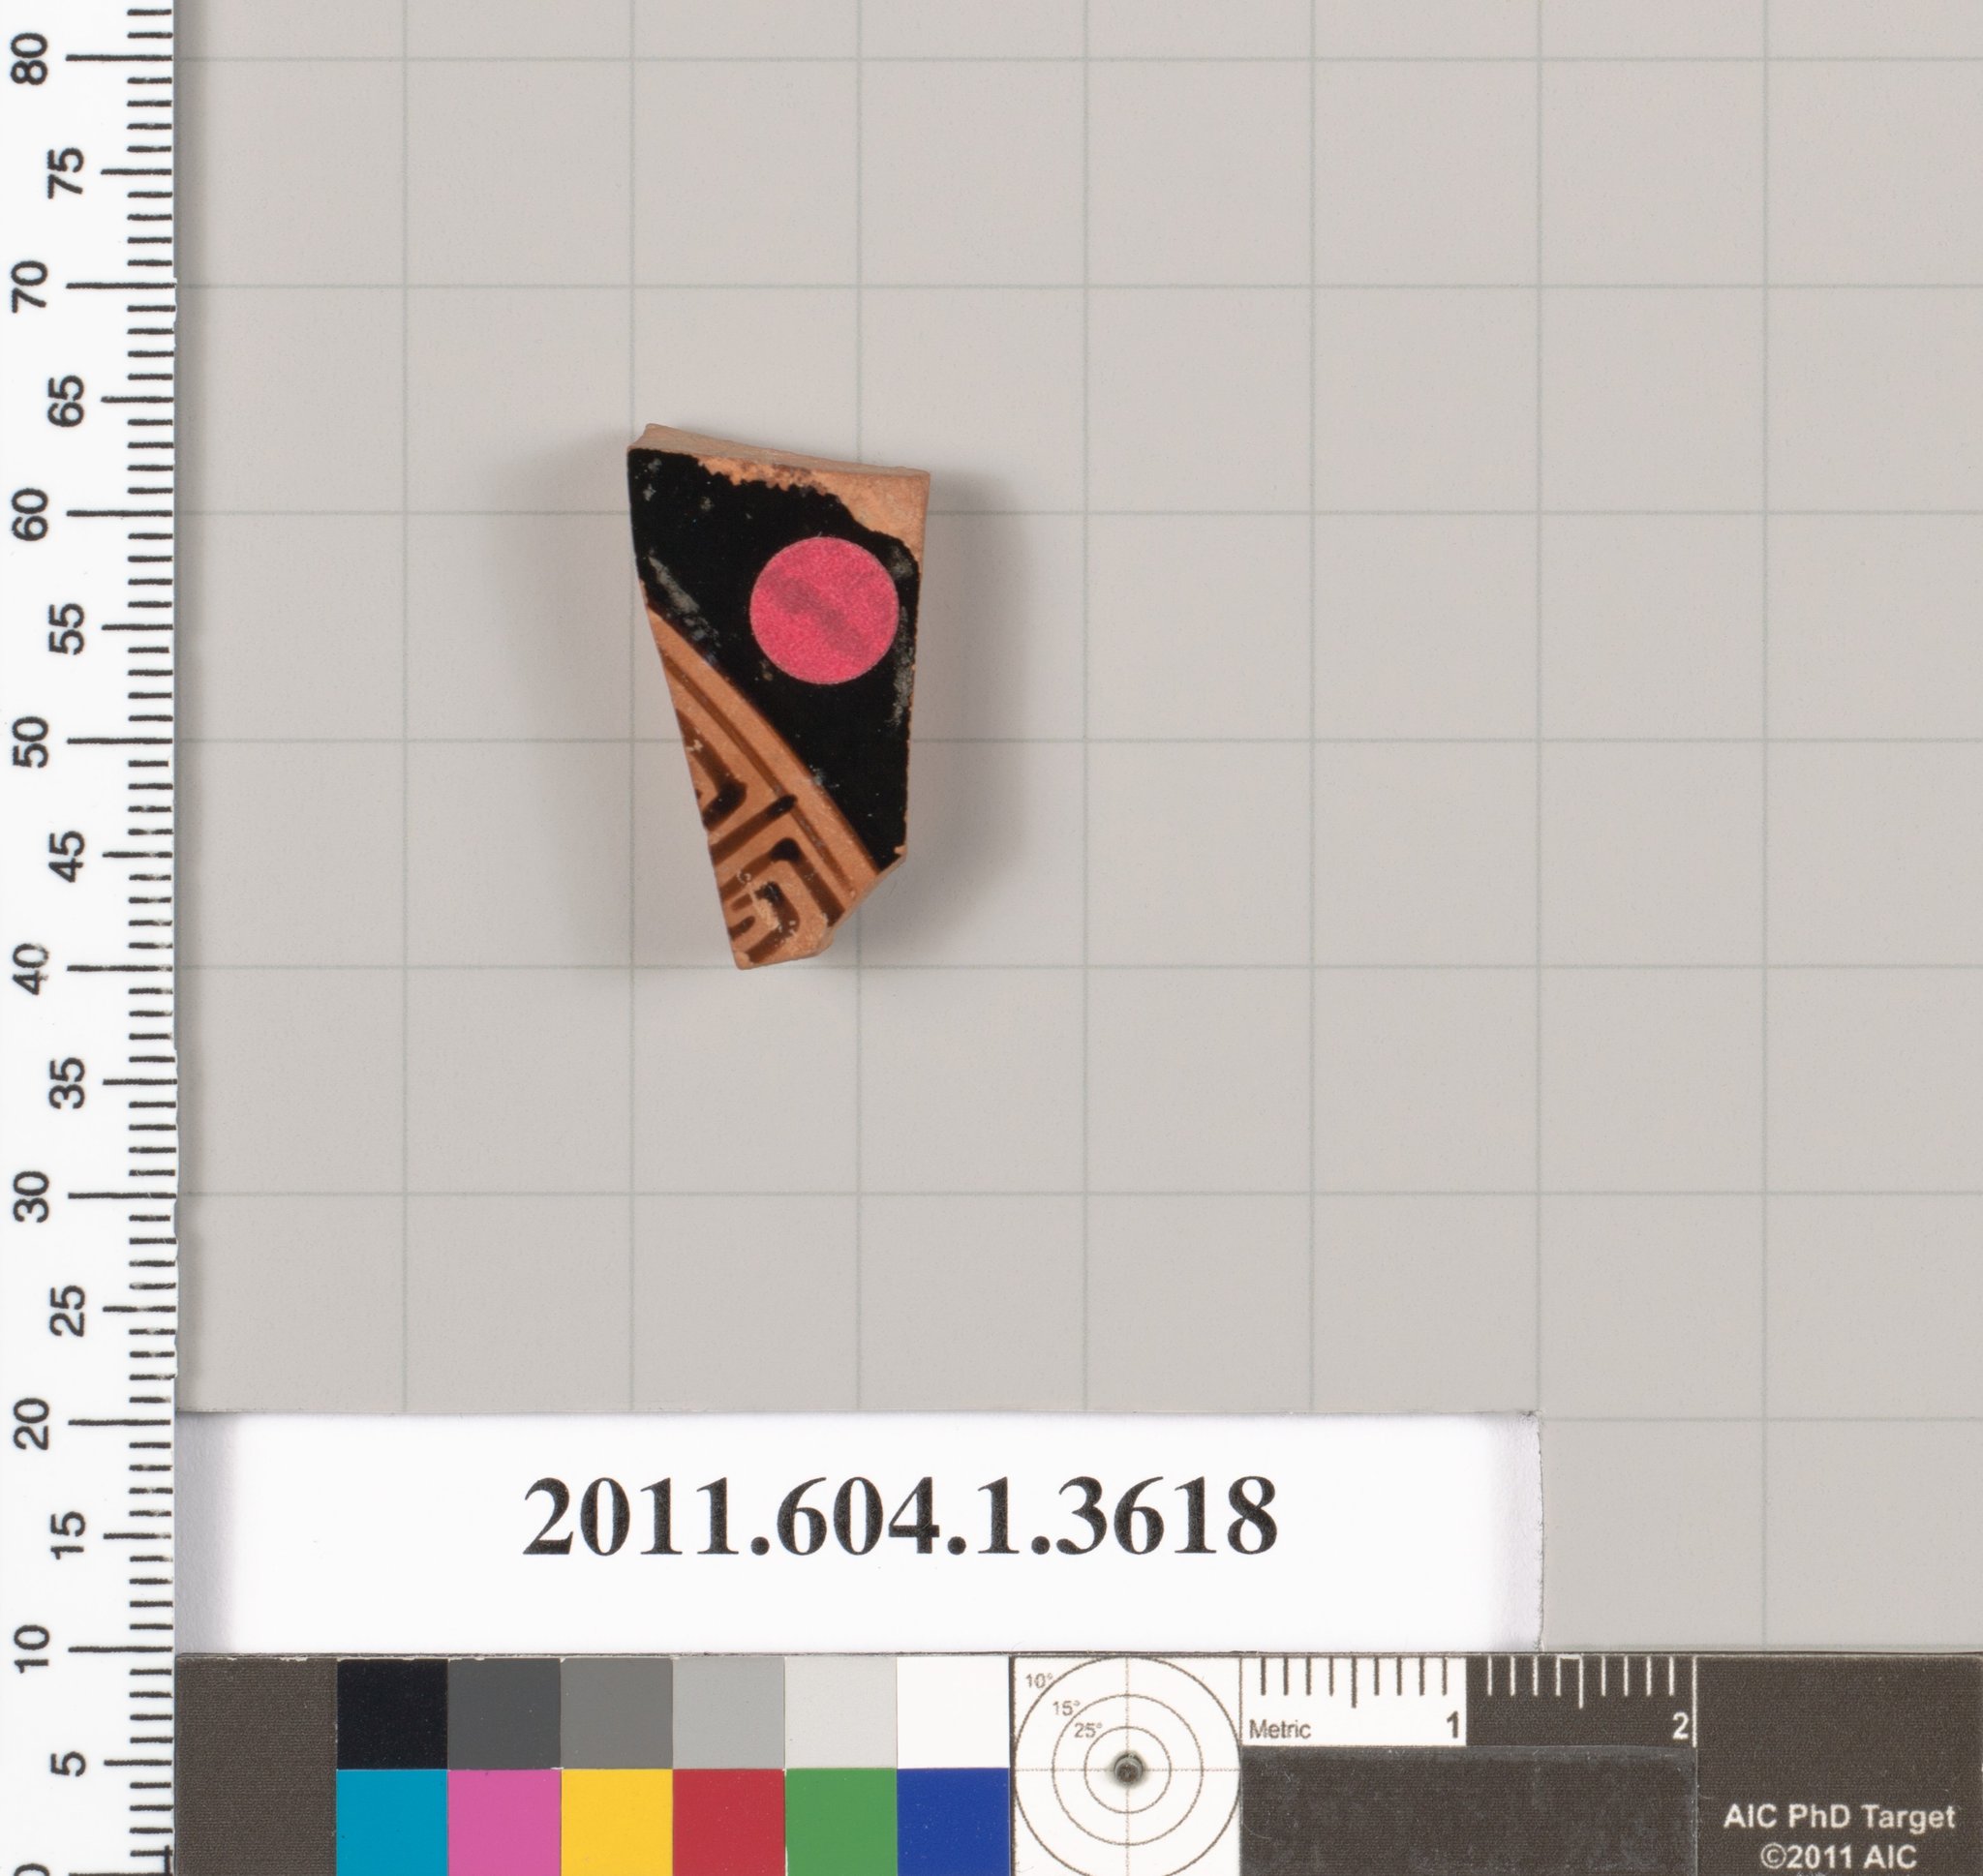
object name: kylix fragment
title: Terracotta fragment of a kylix (drinking cup)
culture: greek, attic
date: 500-470 BCE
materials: terracotta